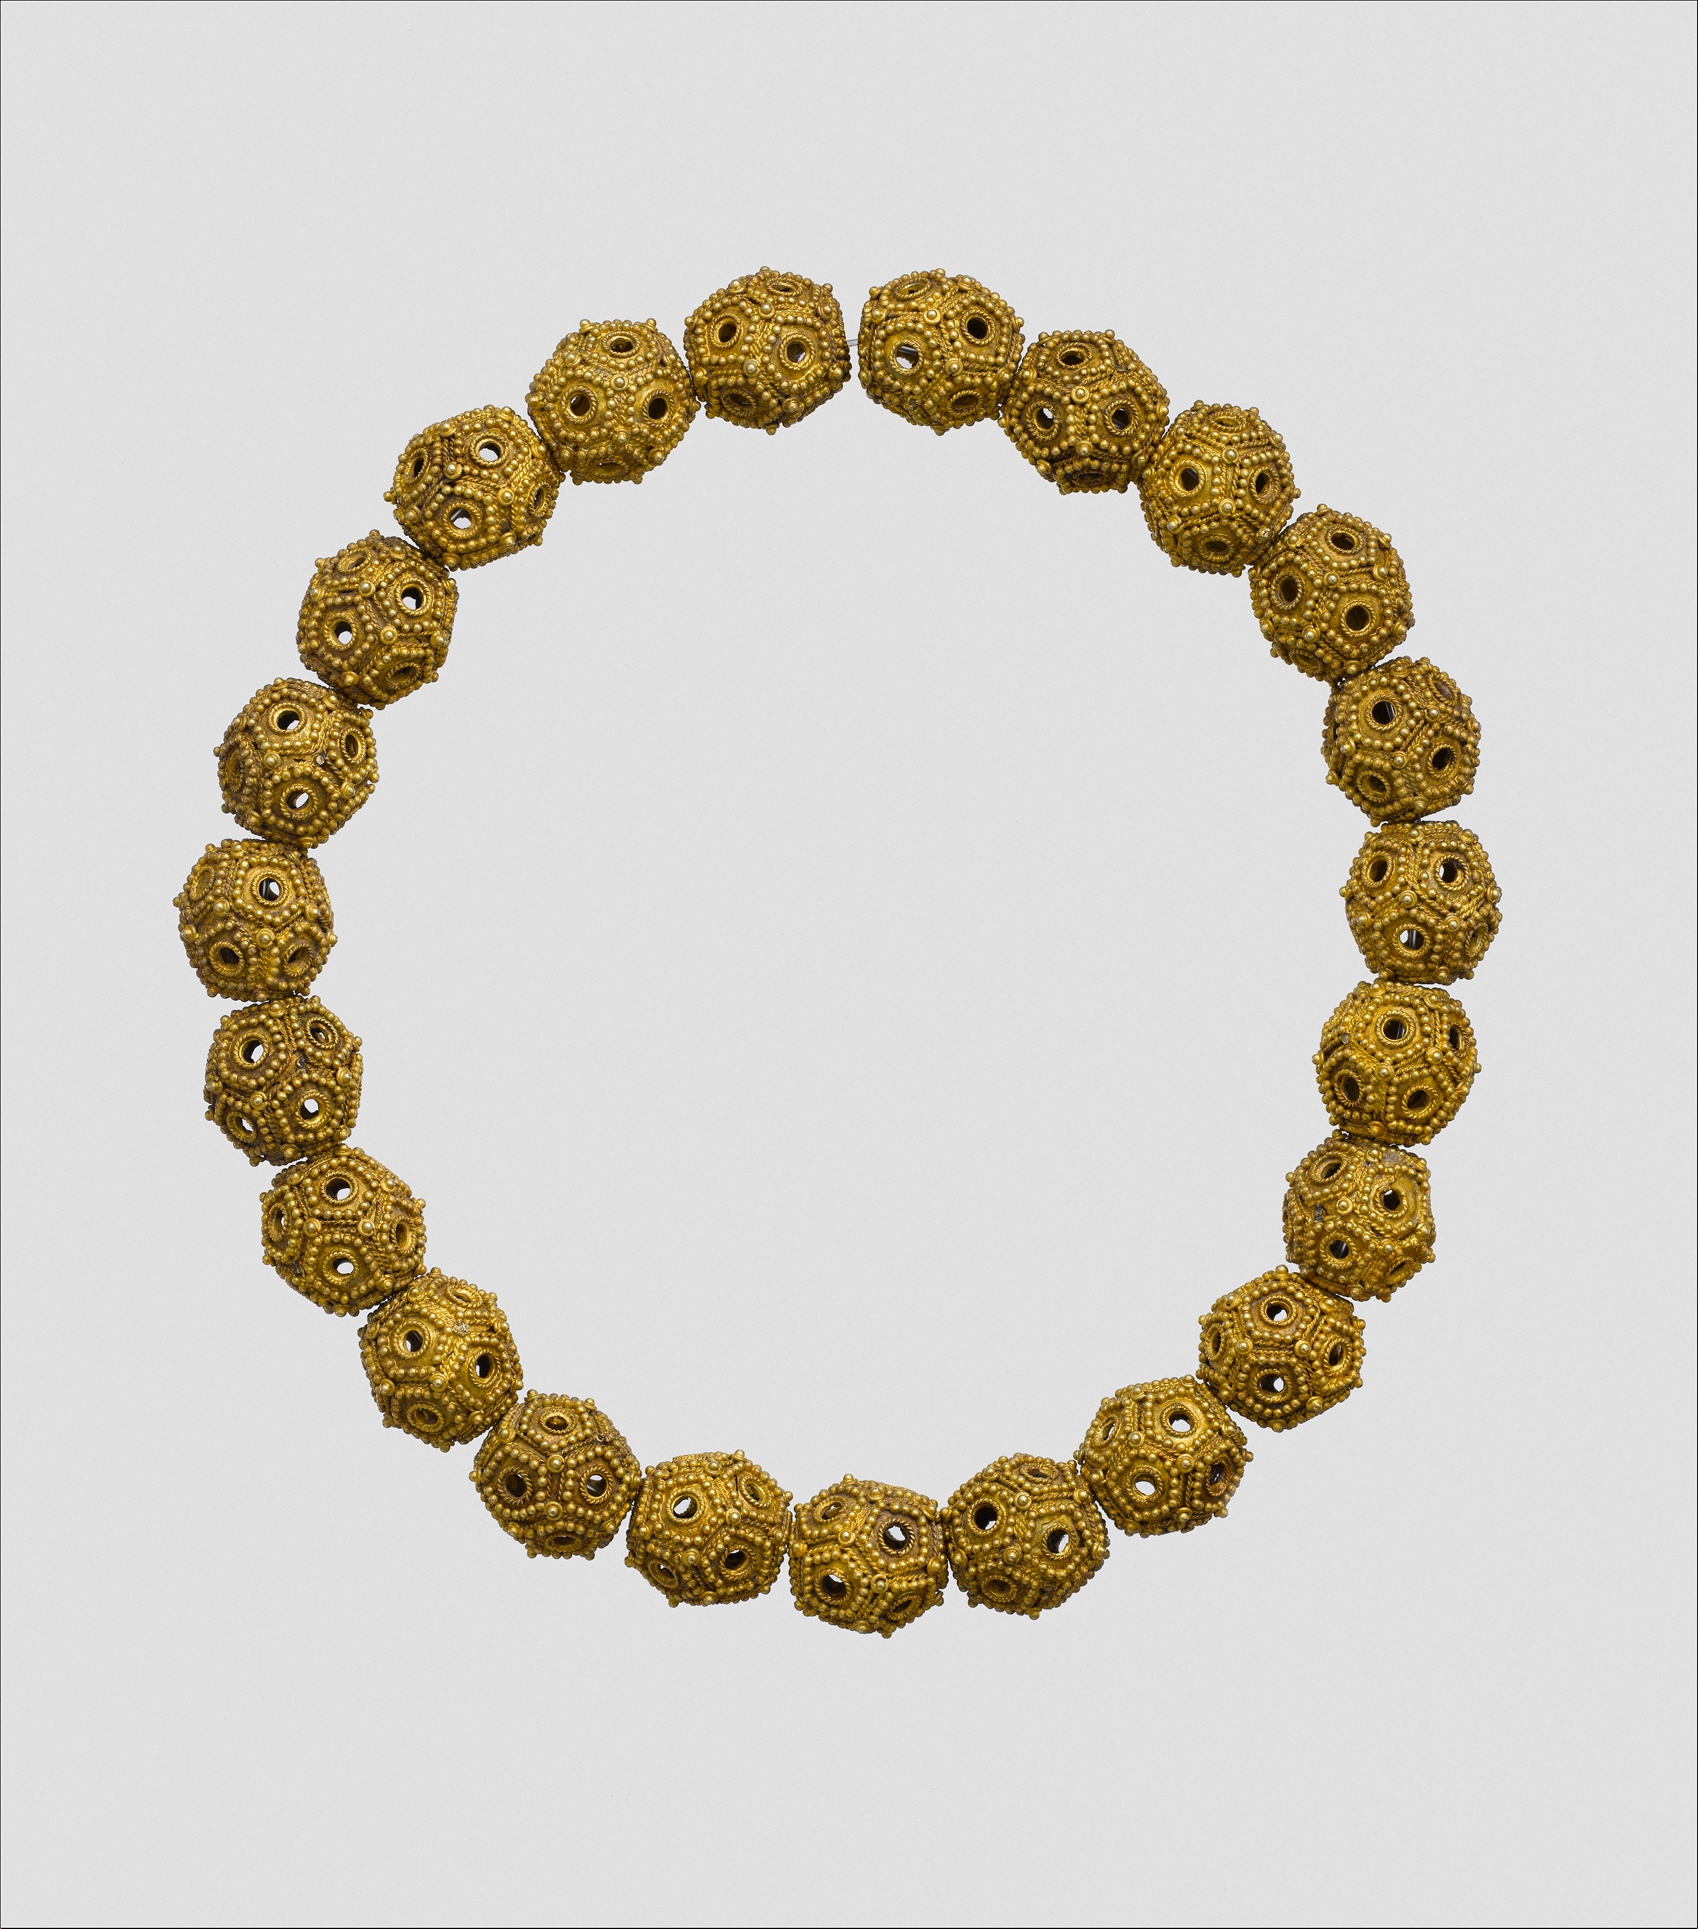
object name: necklace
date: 1001-1200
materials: gold, metal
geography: iran